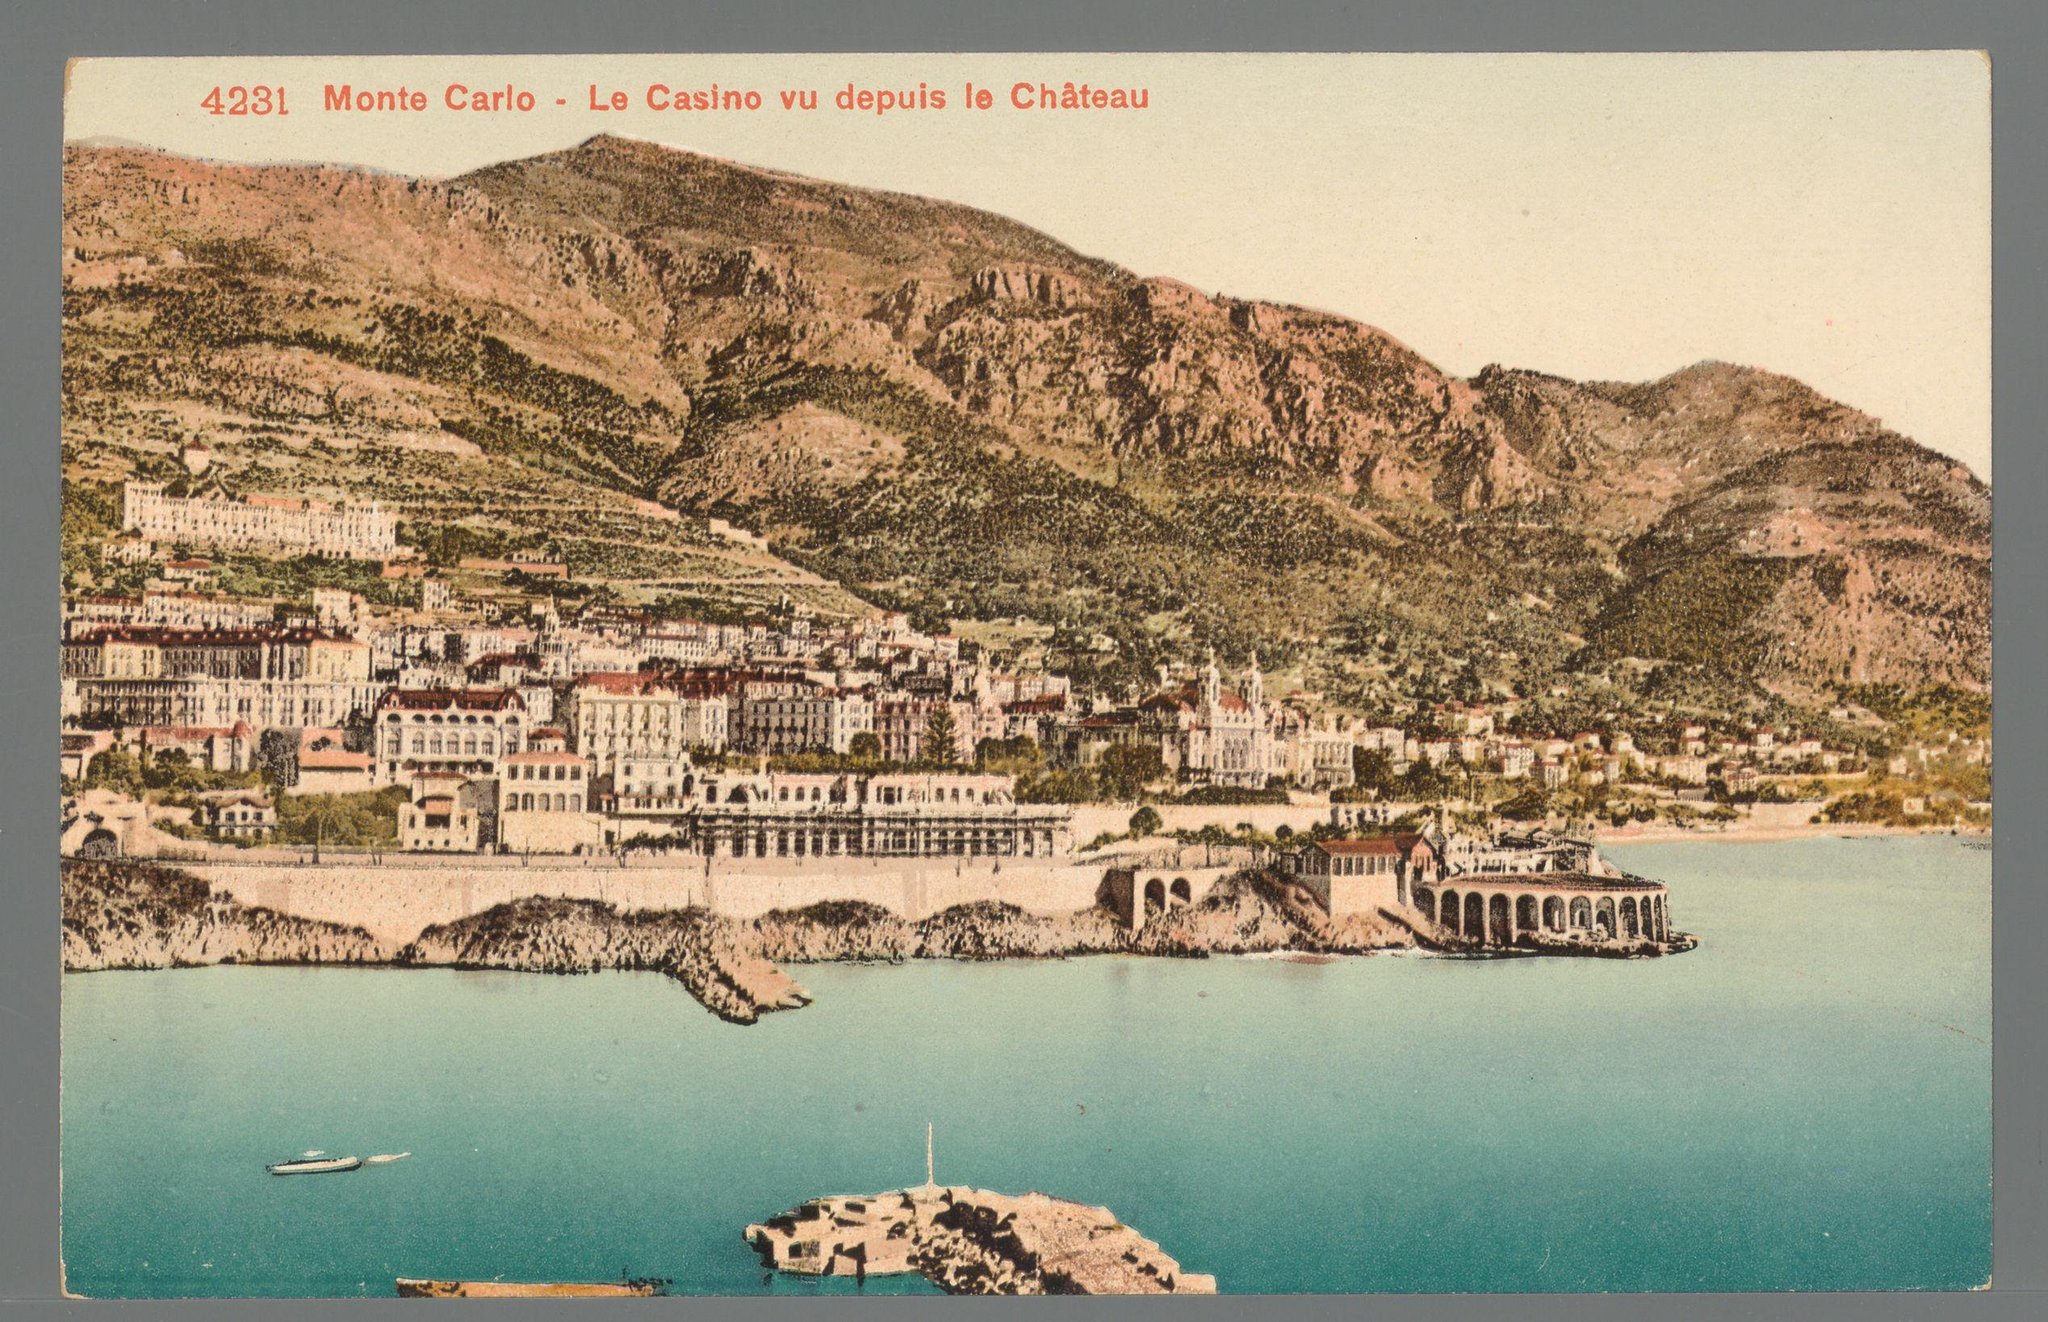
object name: photomechanical print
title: Monte Carlo. Le Casino vu depuis le Château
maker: Anonymous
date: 1903-1930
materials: cardboard, photographic process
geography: monte carlo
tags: sea (seascape), casino, prospect of city, town panorama, silhouette of city